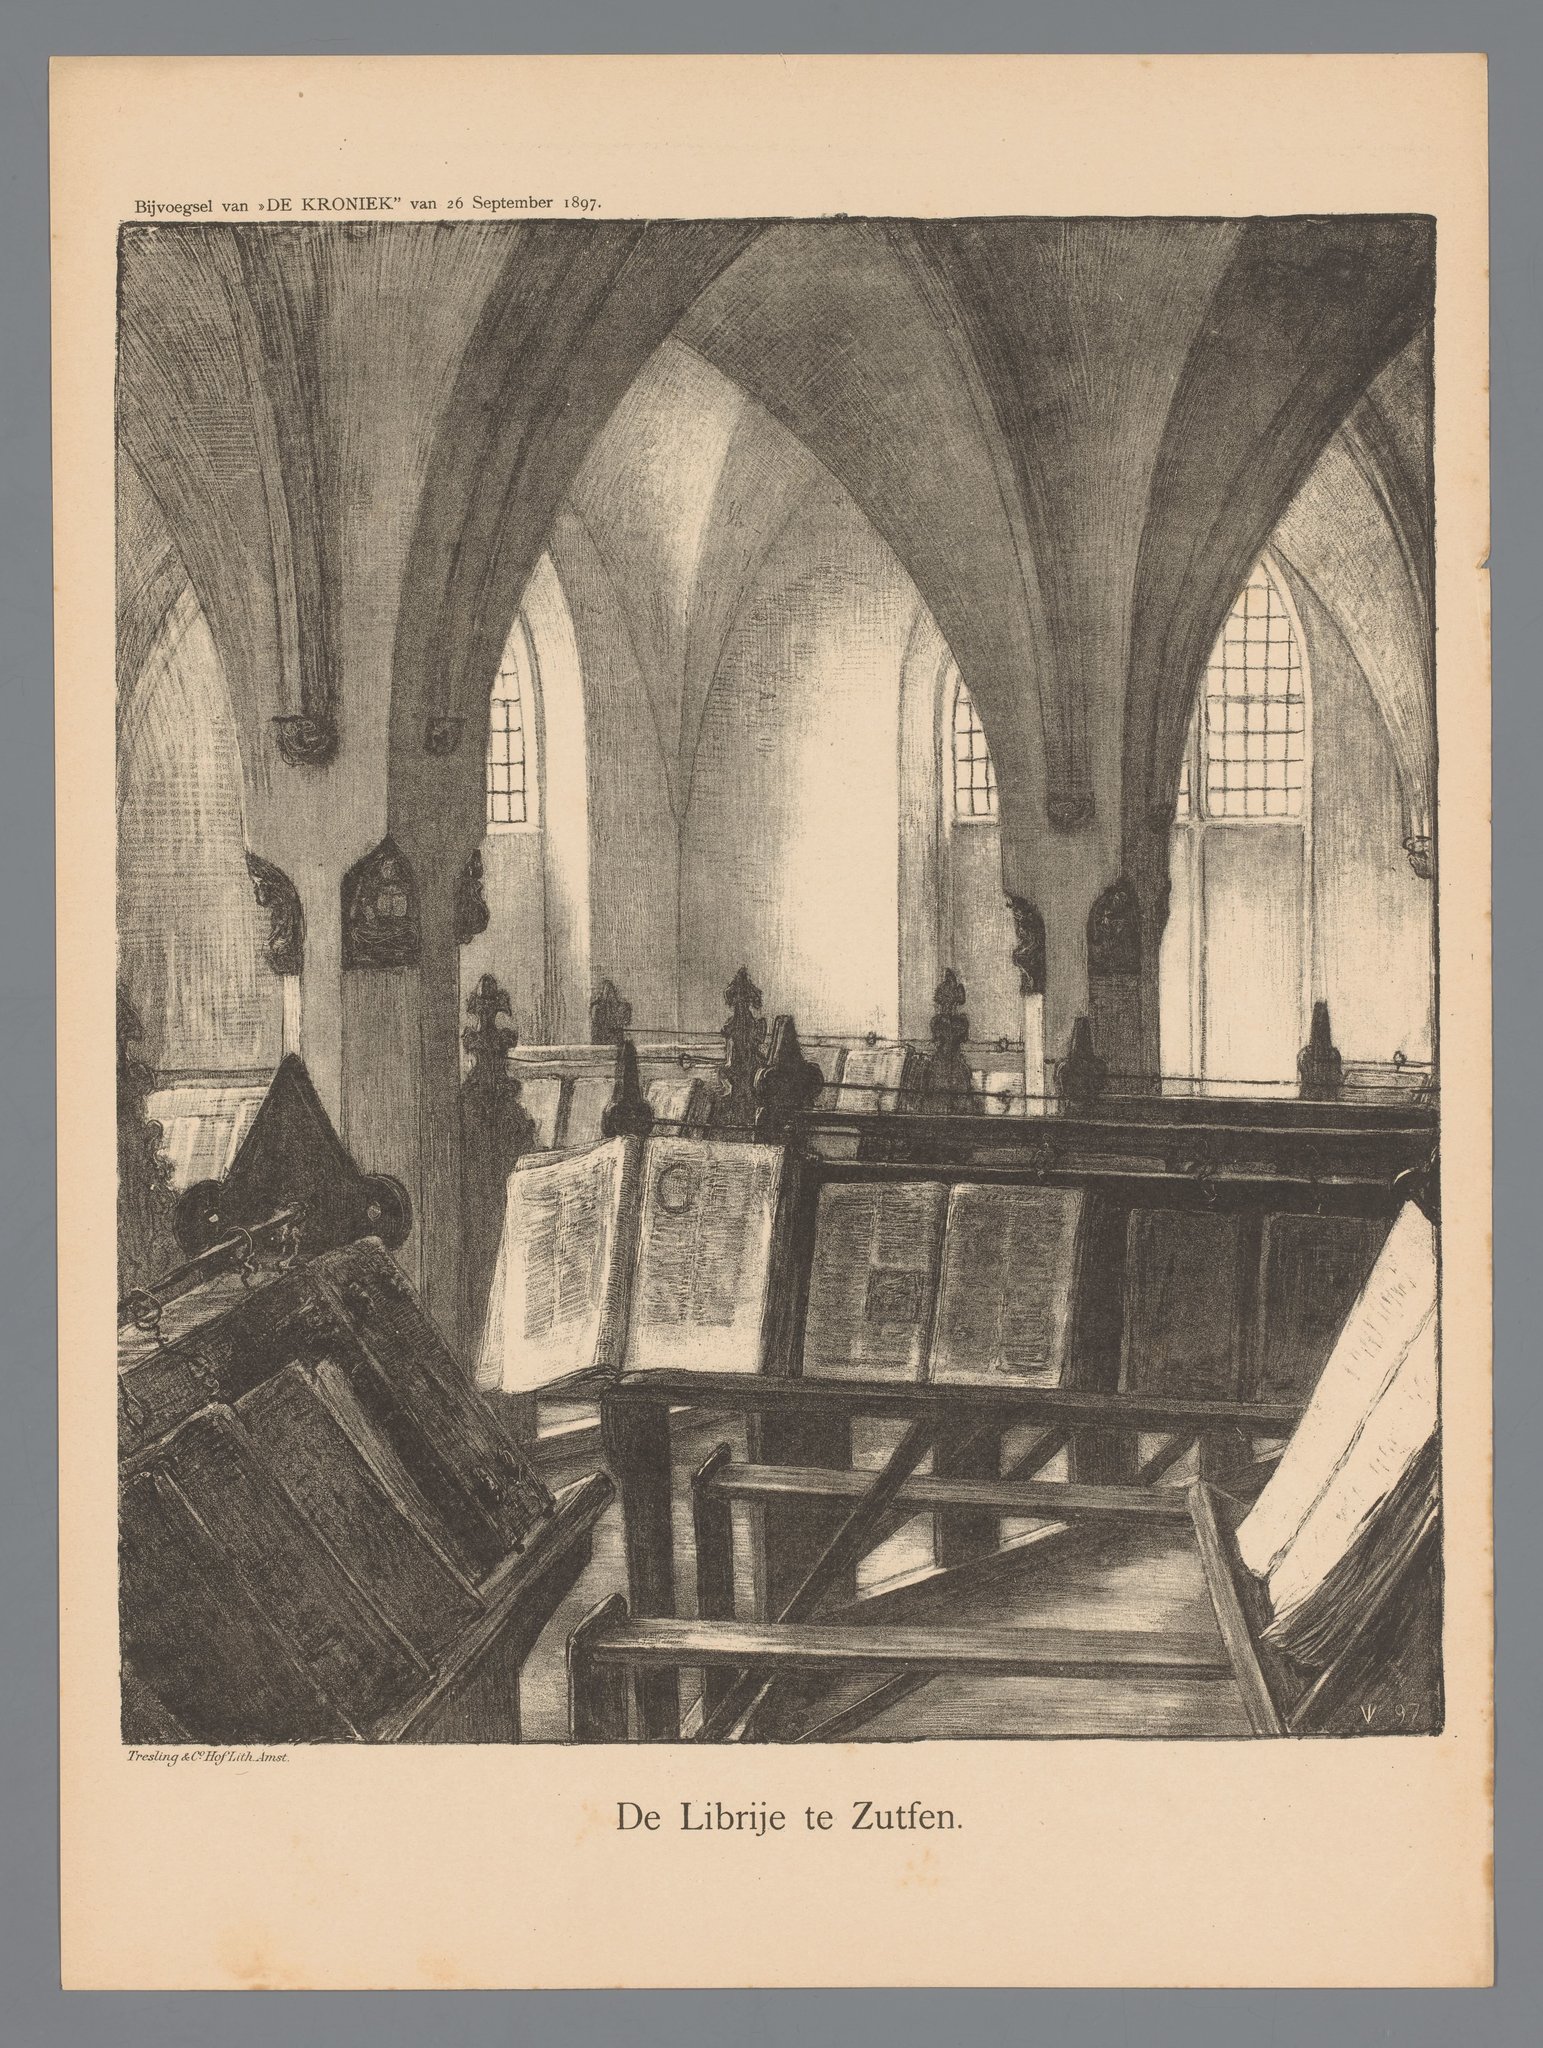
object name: print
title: De Librije te Zutfen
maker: jan veth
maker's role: designer, draughtsman, painter, print maker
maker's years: 1864-1925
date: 1897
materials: paper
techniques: lithograph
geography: amsterdam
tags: public library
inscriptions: date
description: Prent uit het bijvoegsel van: De Kroniek 3 (1897), 26 september 1897.